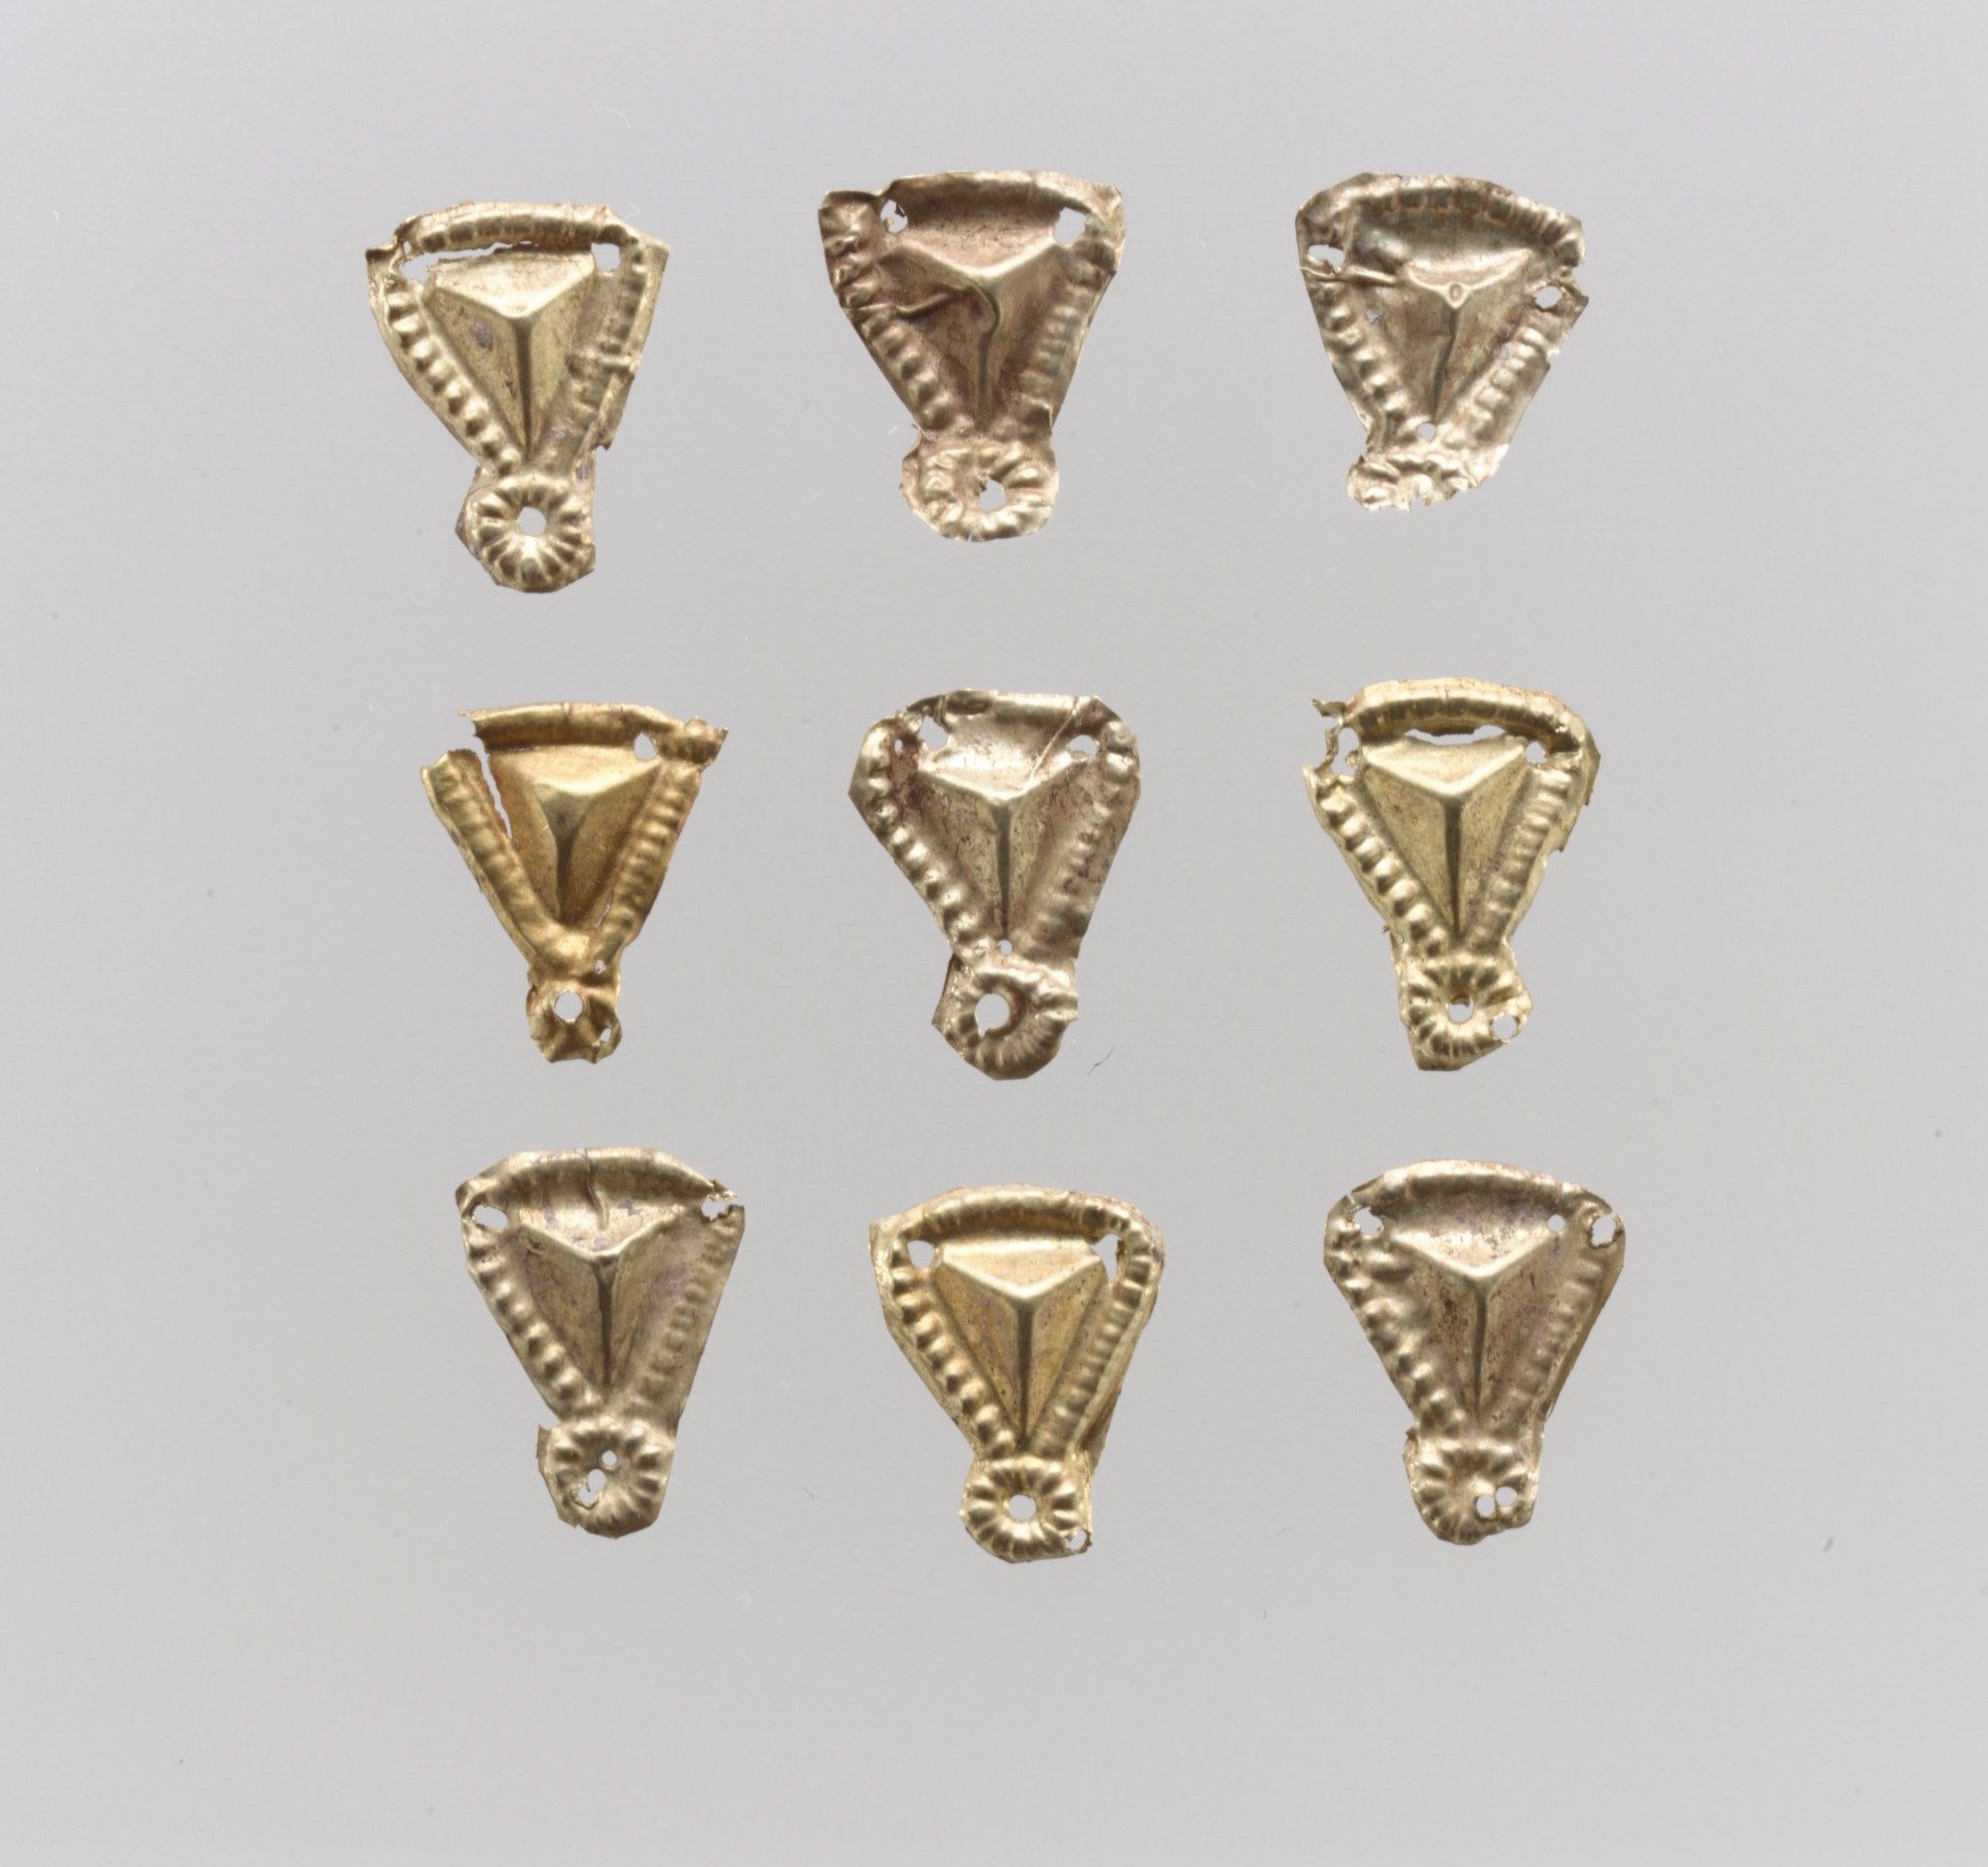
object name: bead ornament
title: Bead ornaments, triangular, 57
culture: east germanic or nomadic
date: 401-450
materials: gold